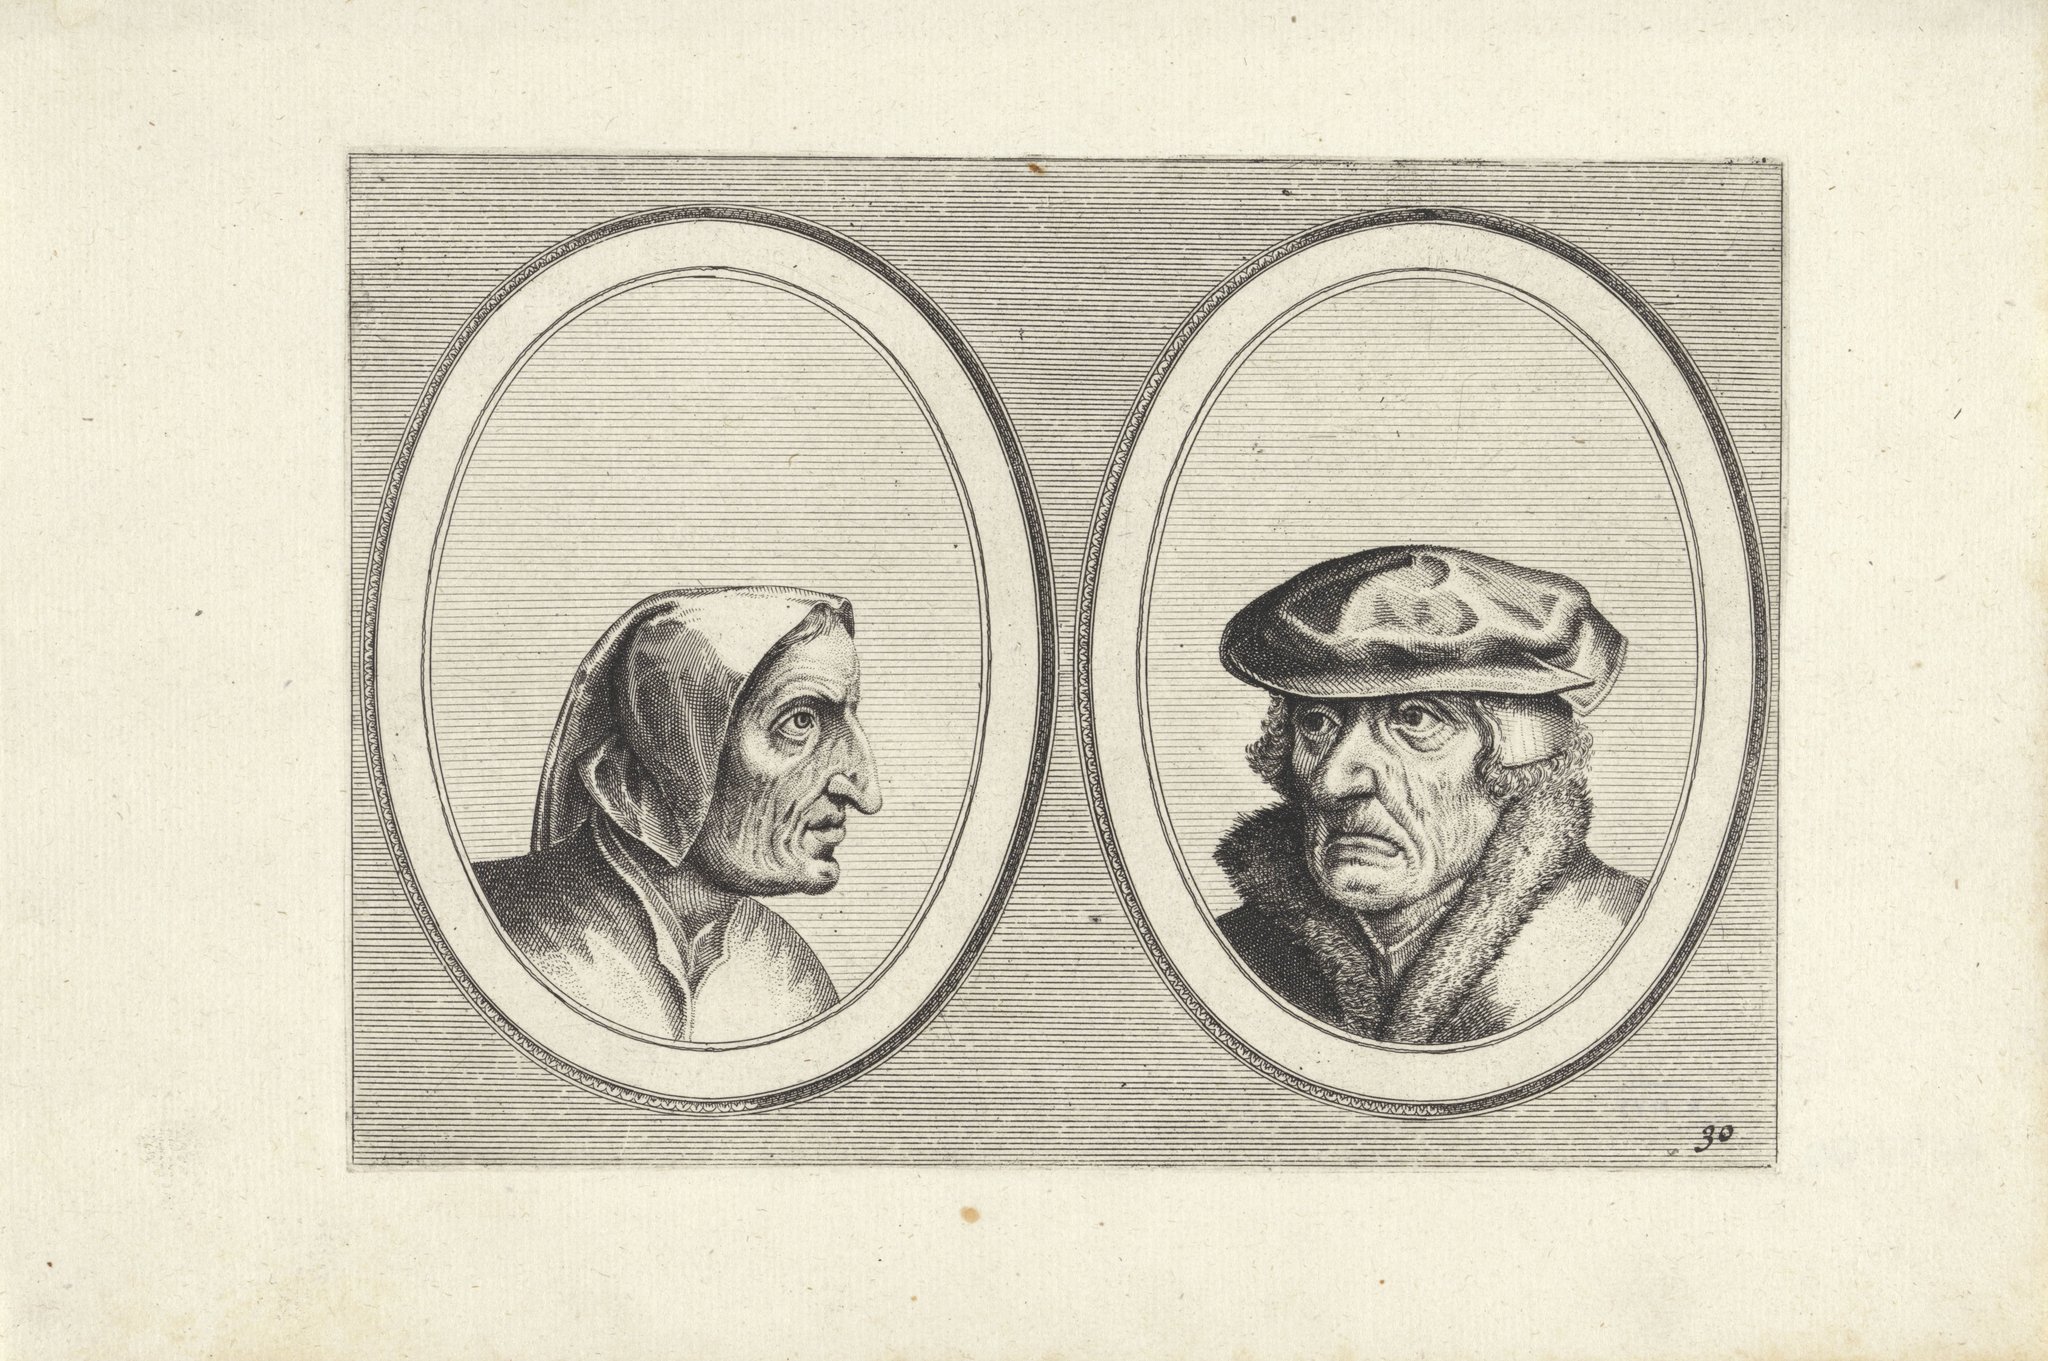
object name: print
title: Boerenkoppen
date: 1612-1652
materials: paper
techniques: engraving, etching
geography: amsterdam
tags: head-gear, farmers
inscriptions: collector's mark: Lugt 2228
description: Prent uit een serie van 36 prenten met koppen van boeren en boerinnen.